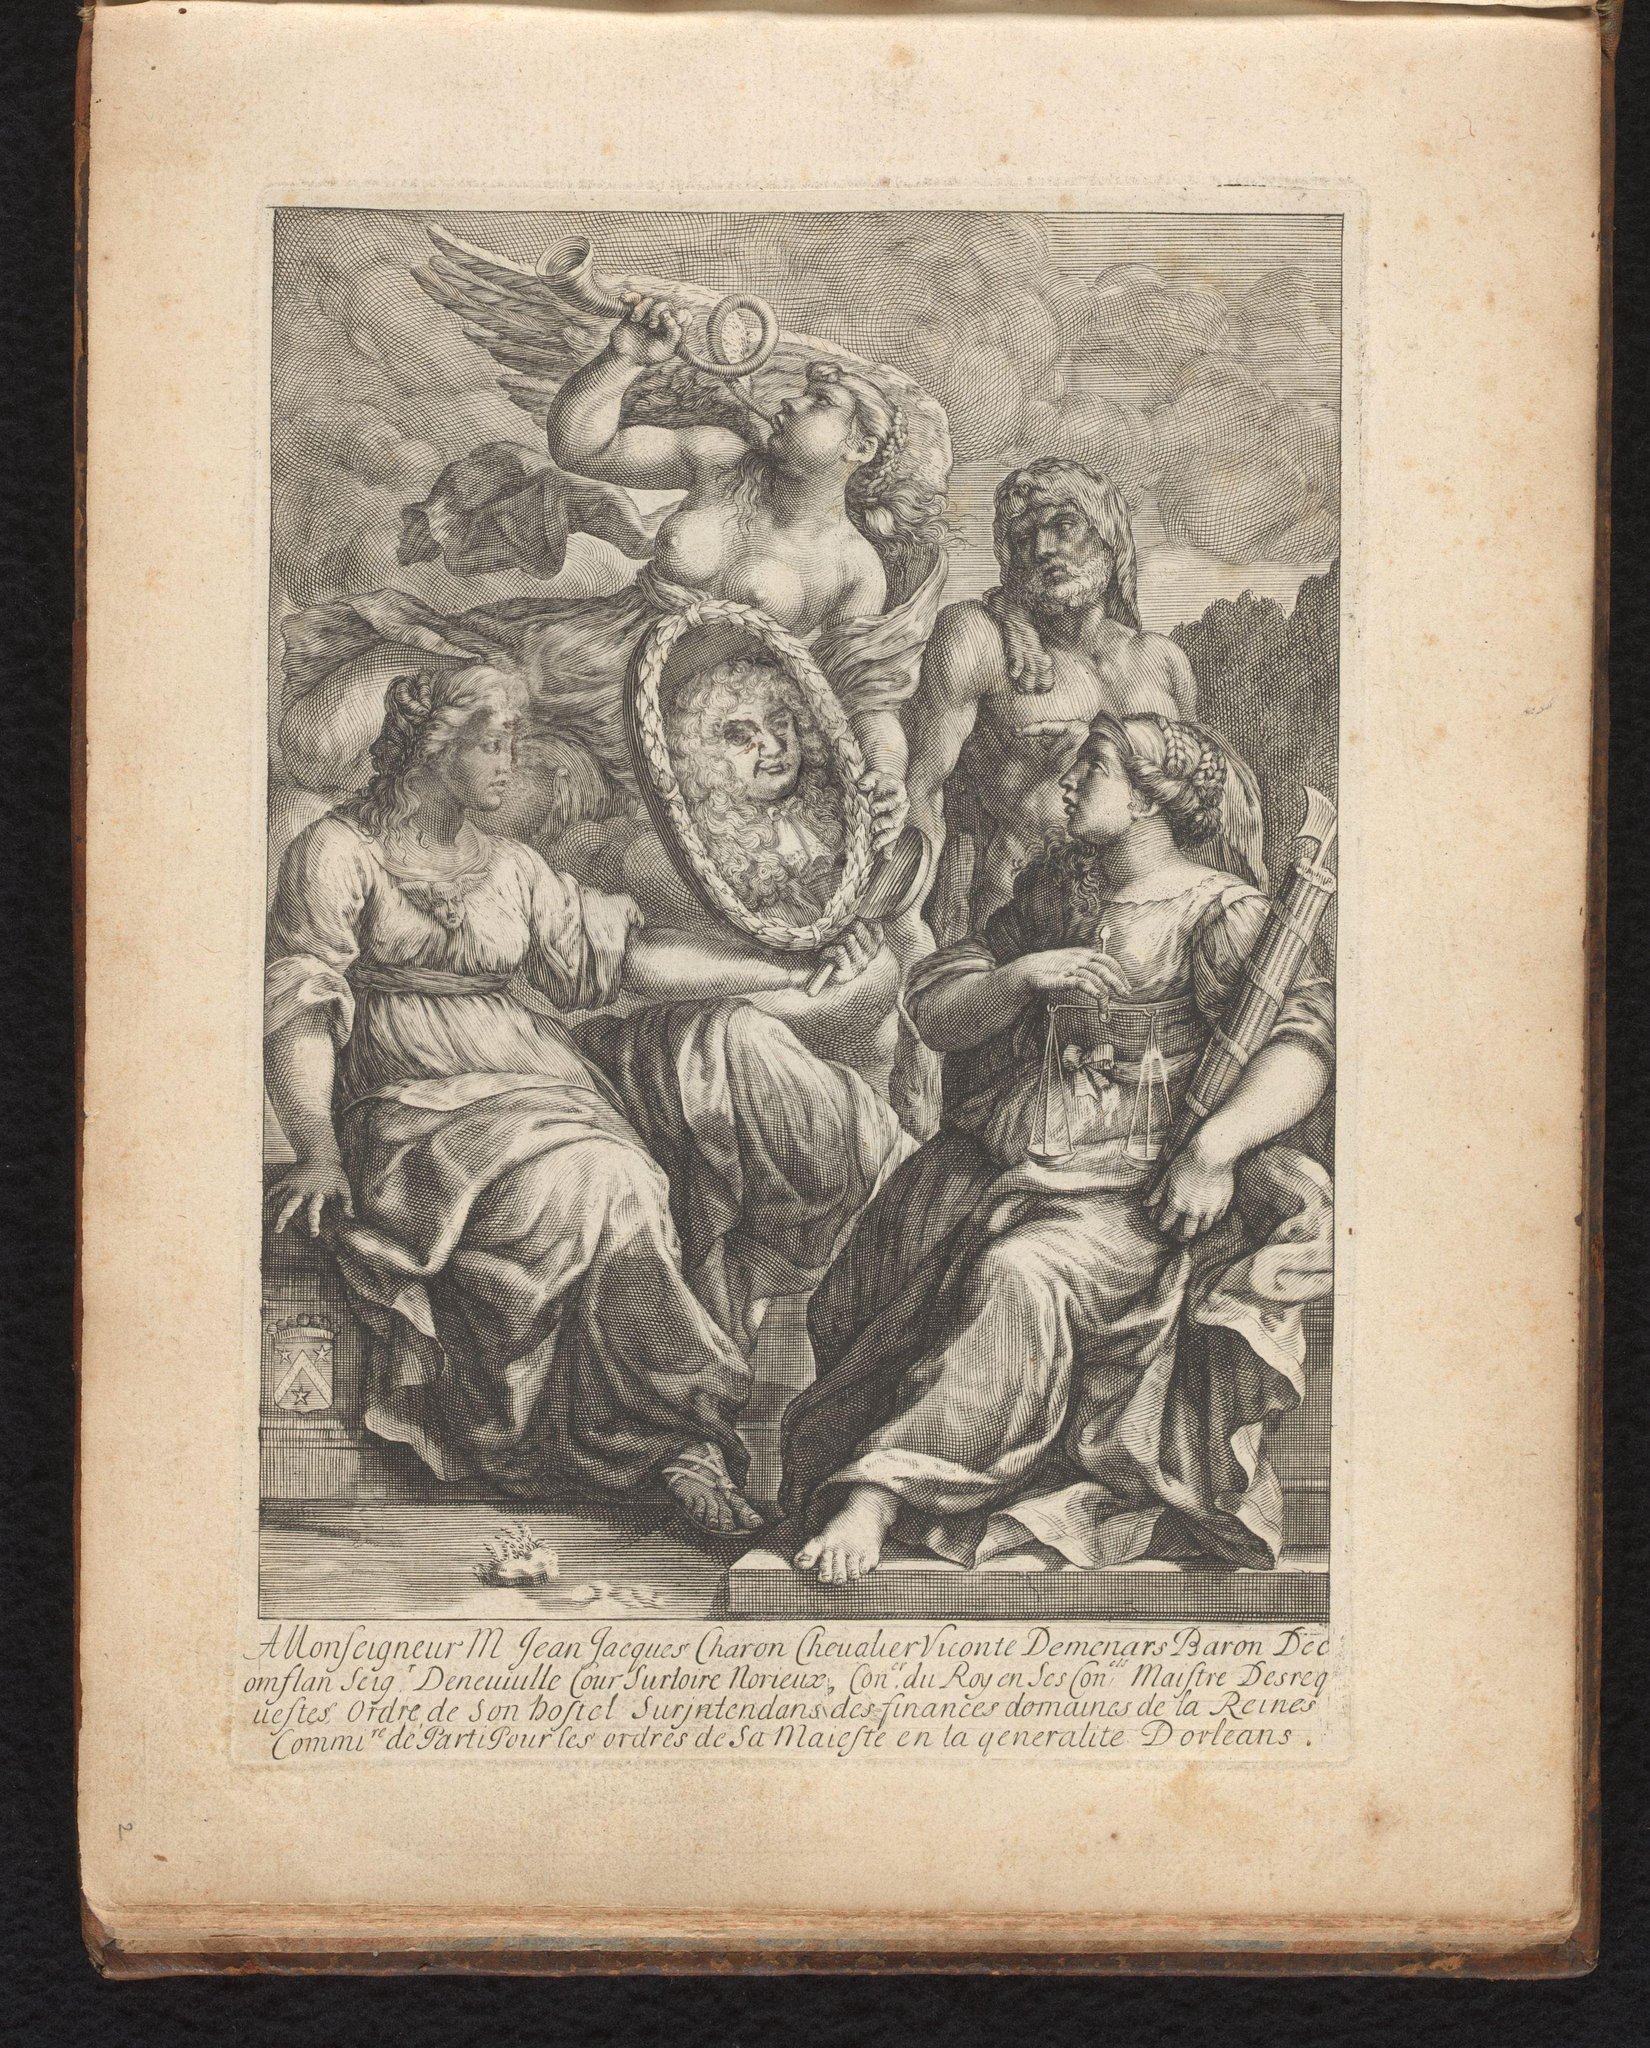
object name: album leaf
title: Door Faam gedragen portret van Jean Jacques Charron bij drie personificaties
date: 1650-1676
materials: paper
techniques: engraving, etching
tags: jean jacques marquis de menars charron, fame; 'fama', 'fama buona', 'fama chiara' (ripa), letter combinations such as letterword, anagram, letter square, monogram, etc.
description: Deze prent maakt deel uit van een album.